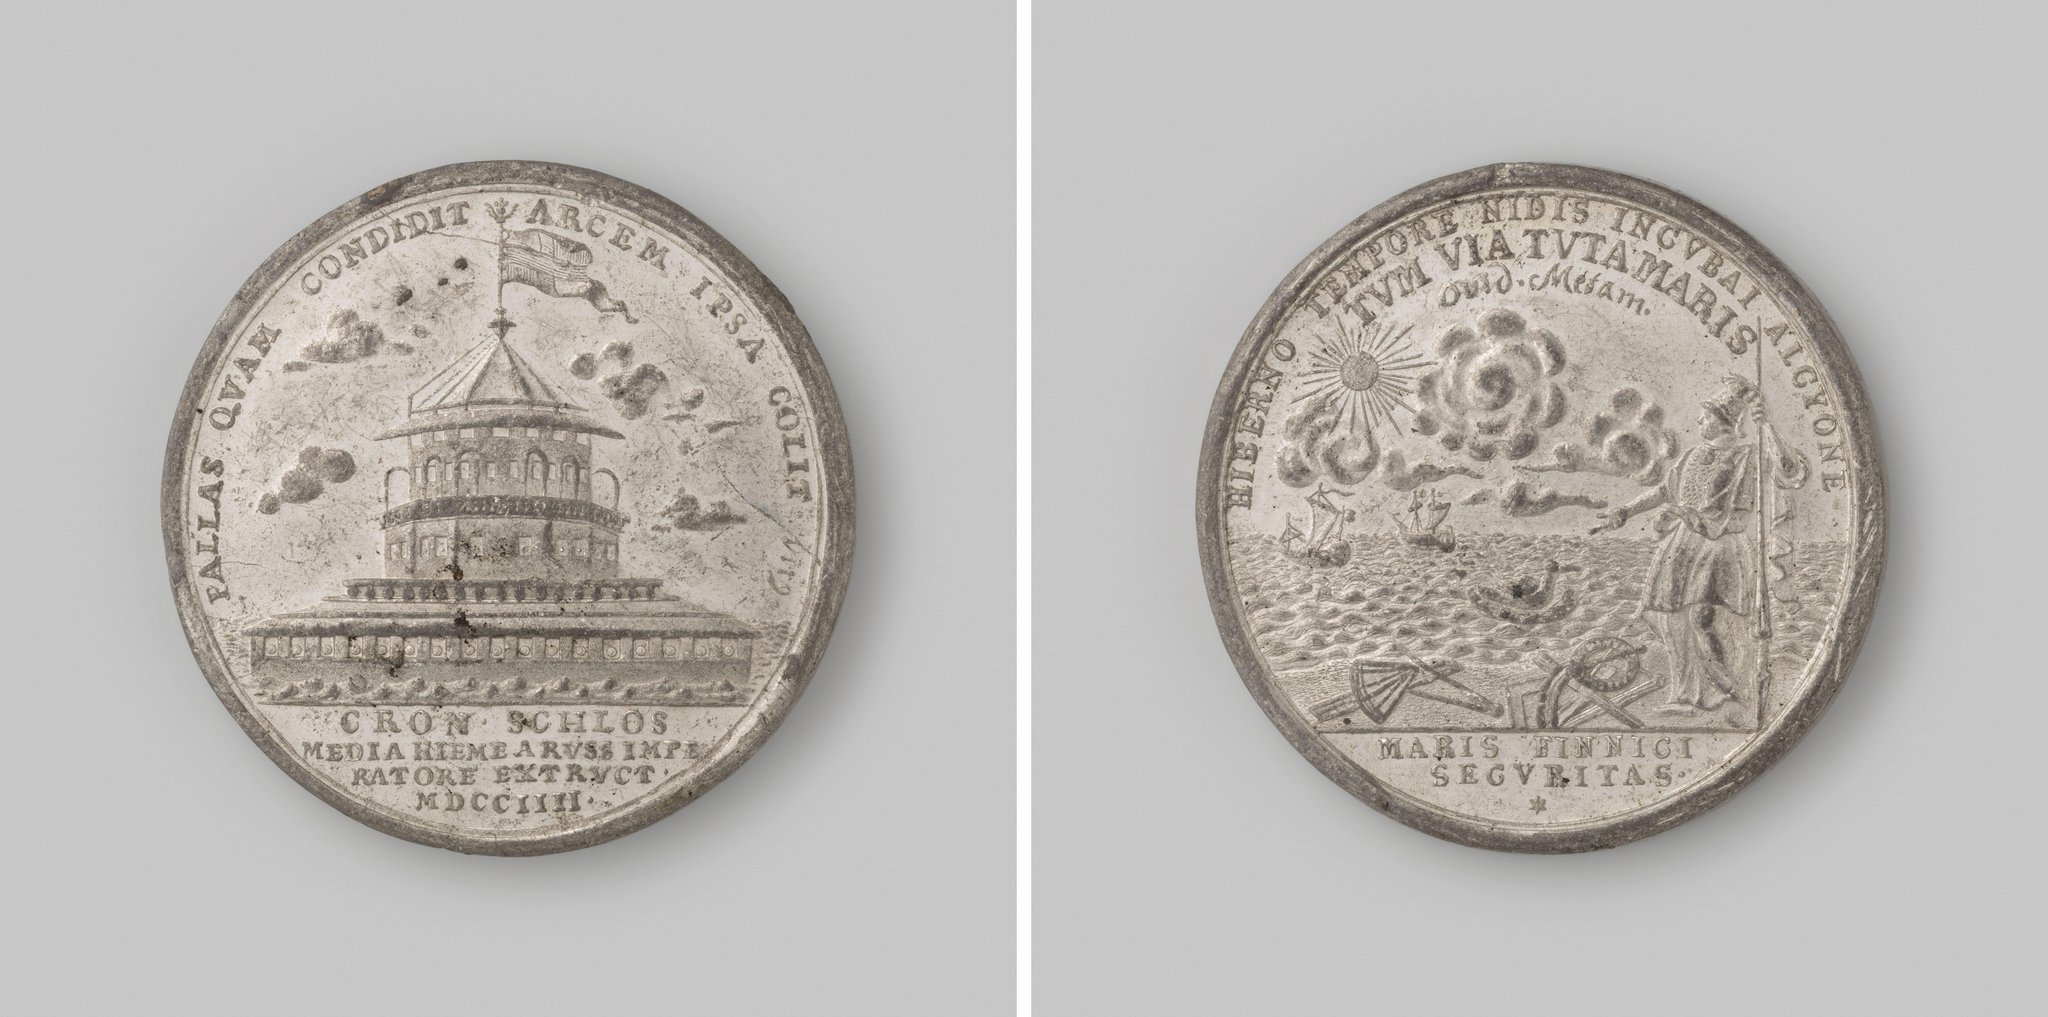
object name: history medal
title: Stichting van het fort Cronschlosz in Cronstadt door Tsaar Peter de Grote 1704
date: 1704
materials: tin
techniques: striking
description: Tinnen penning, op de voorzijde het aanzicht van het fort Cronschlosz met omschrift en afsnedetekst, op de keerzijde Athena, aan haar voeten nautische instrumenten, staand bij een zonbeschenen zee met schepen en een ijsvogel op een drijvend nest, met drievoudig omschrift en afsnedetekst.